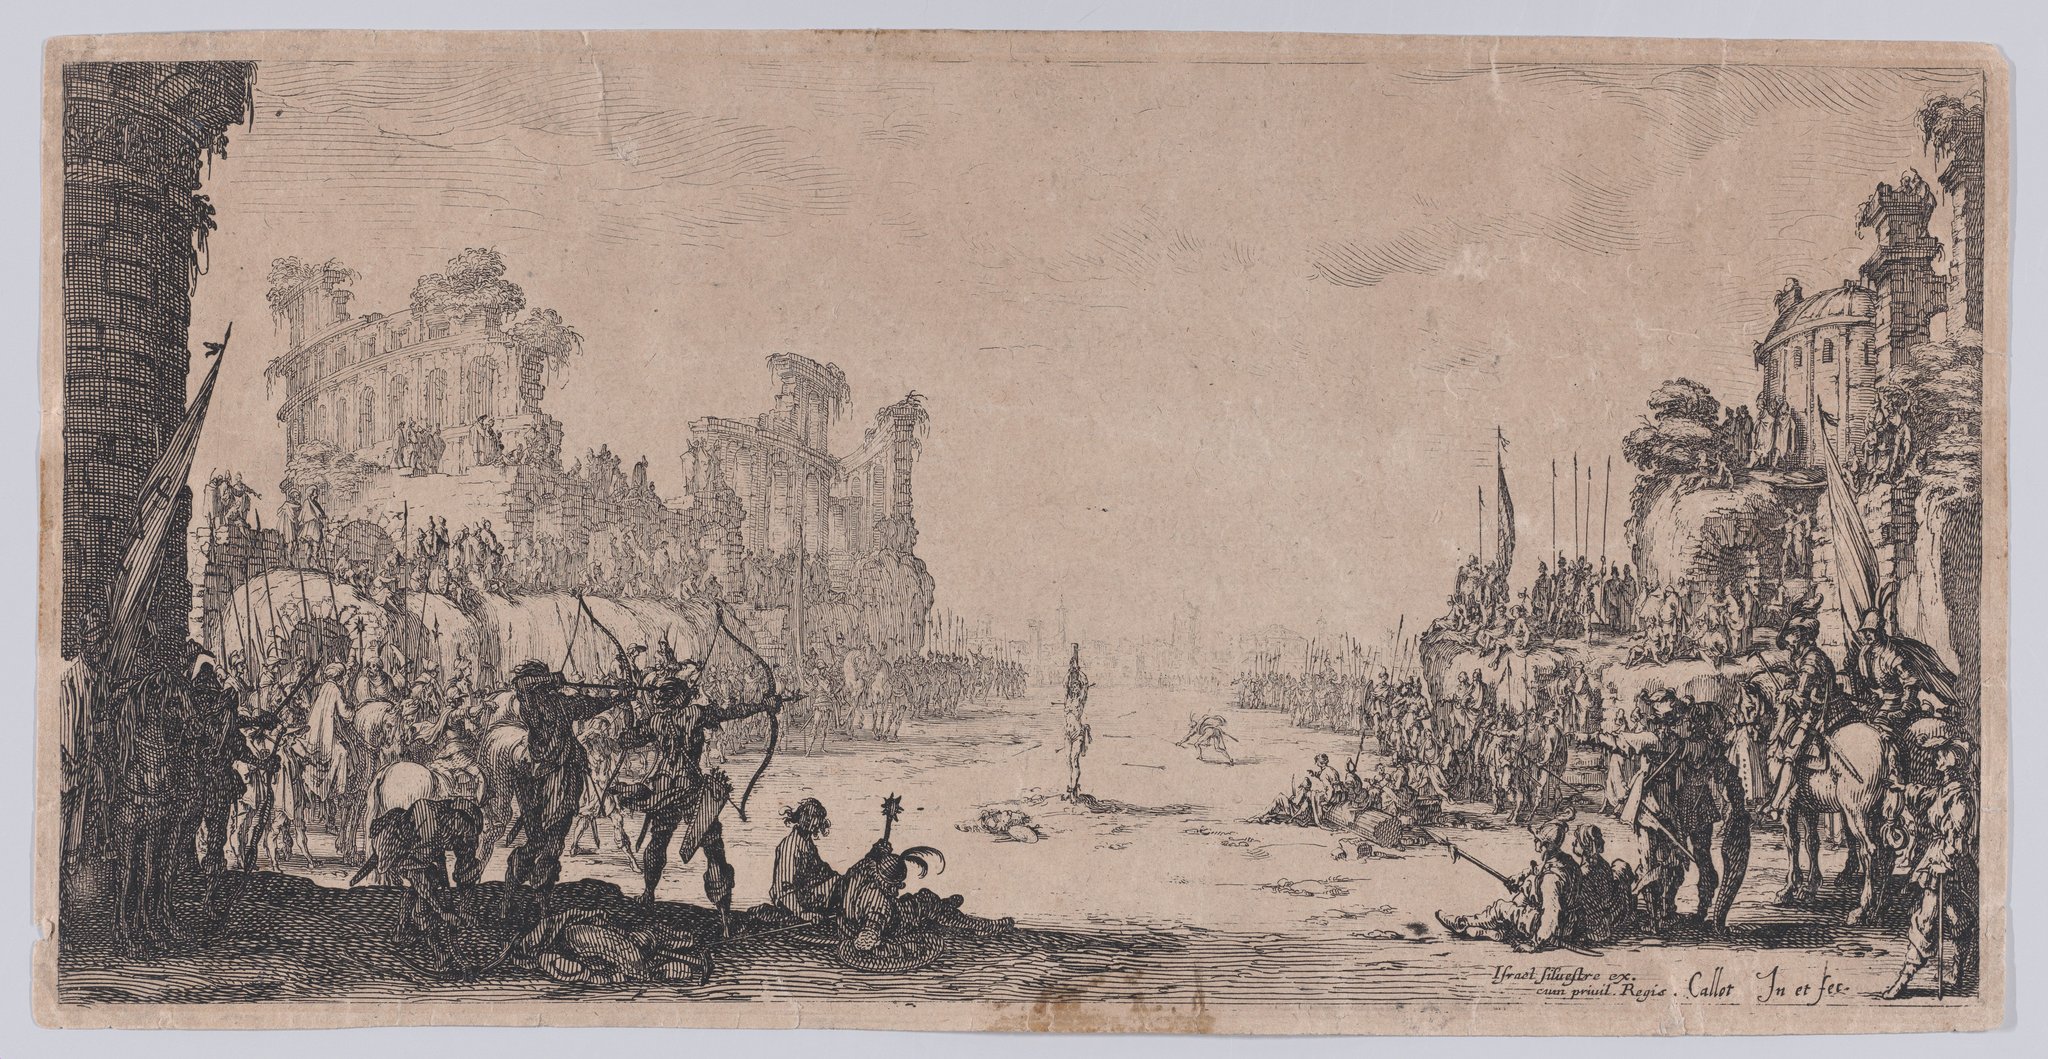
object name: print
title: Le Martyre de St. Sébastien (The Martyrdom of St. Sebastian)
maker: jacques callot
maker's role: artist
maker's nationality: french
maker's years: 1592-1635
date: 1630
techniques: engraving, etching